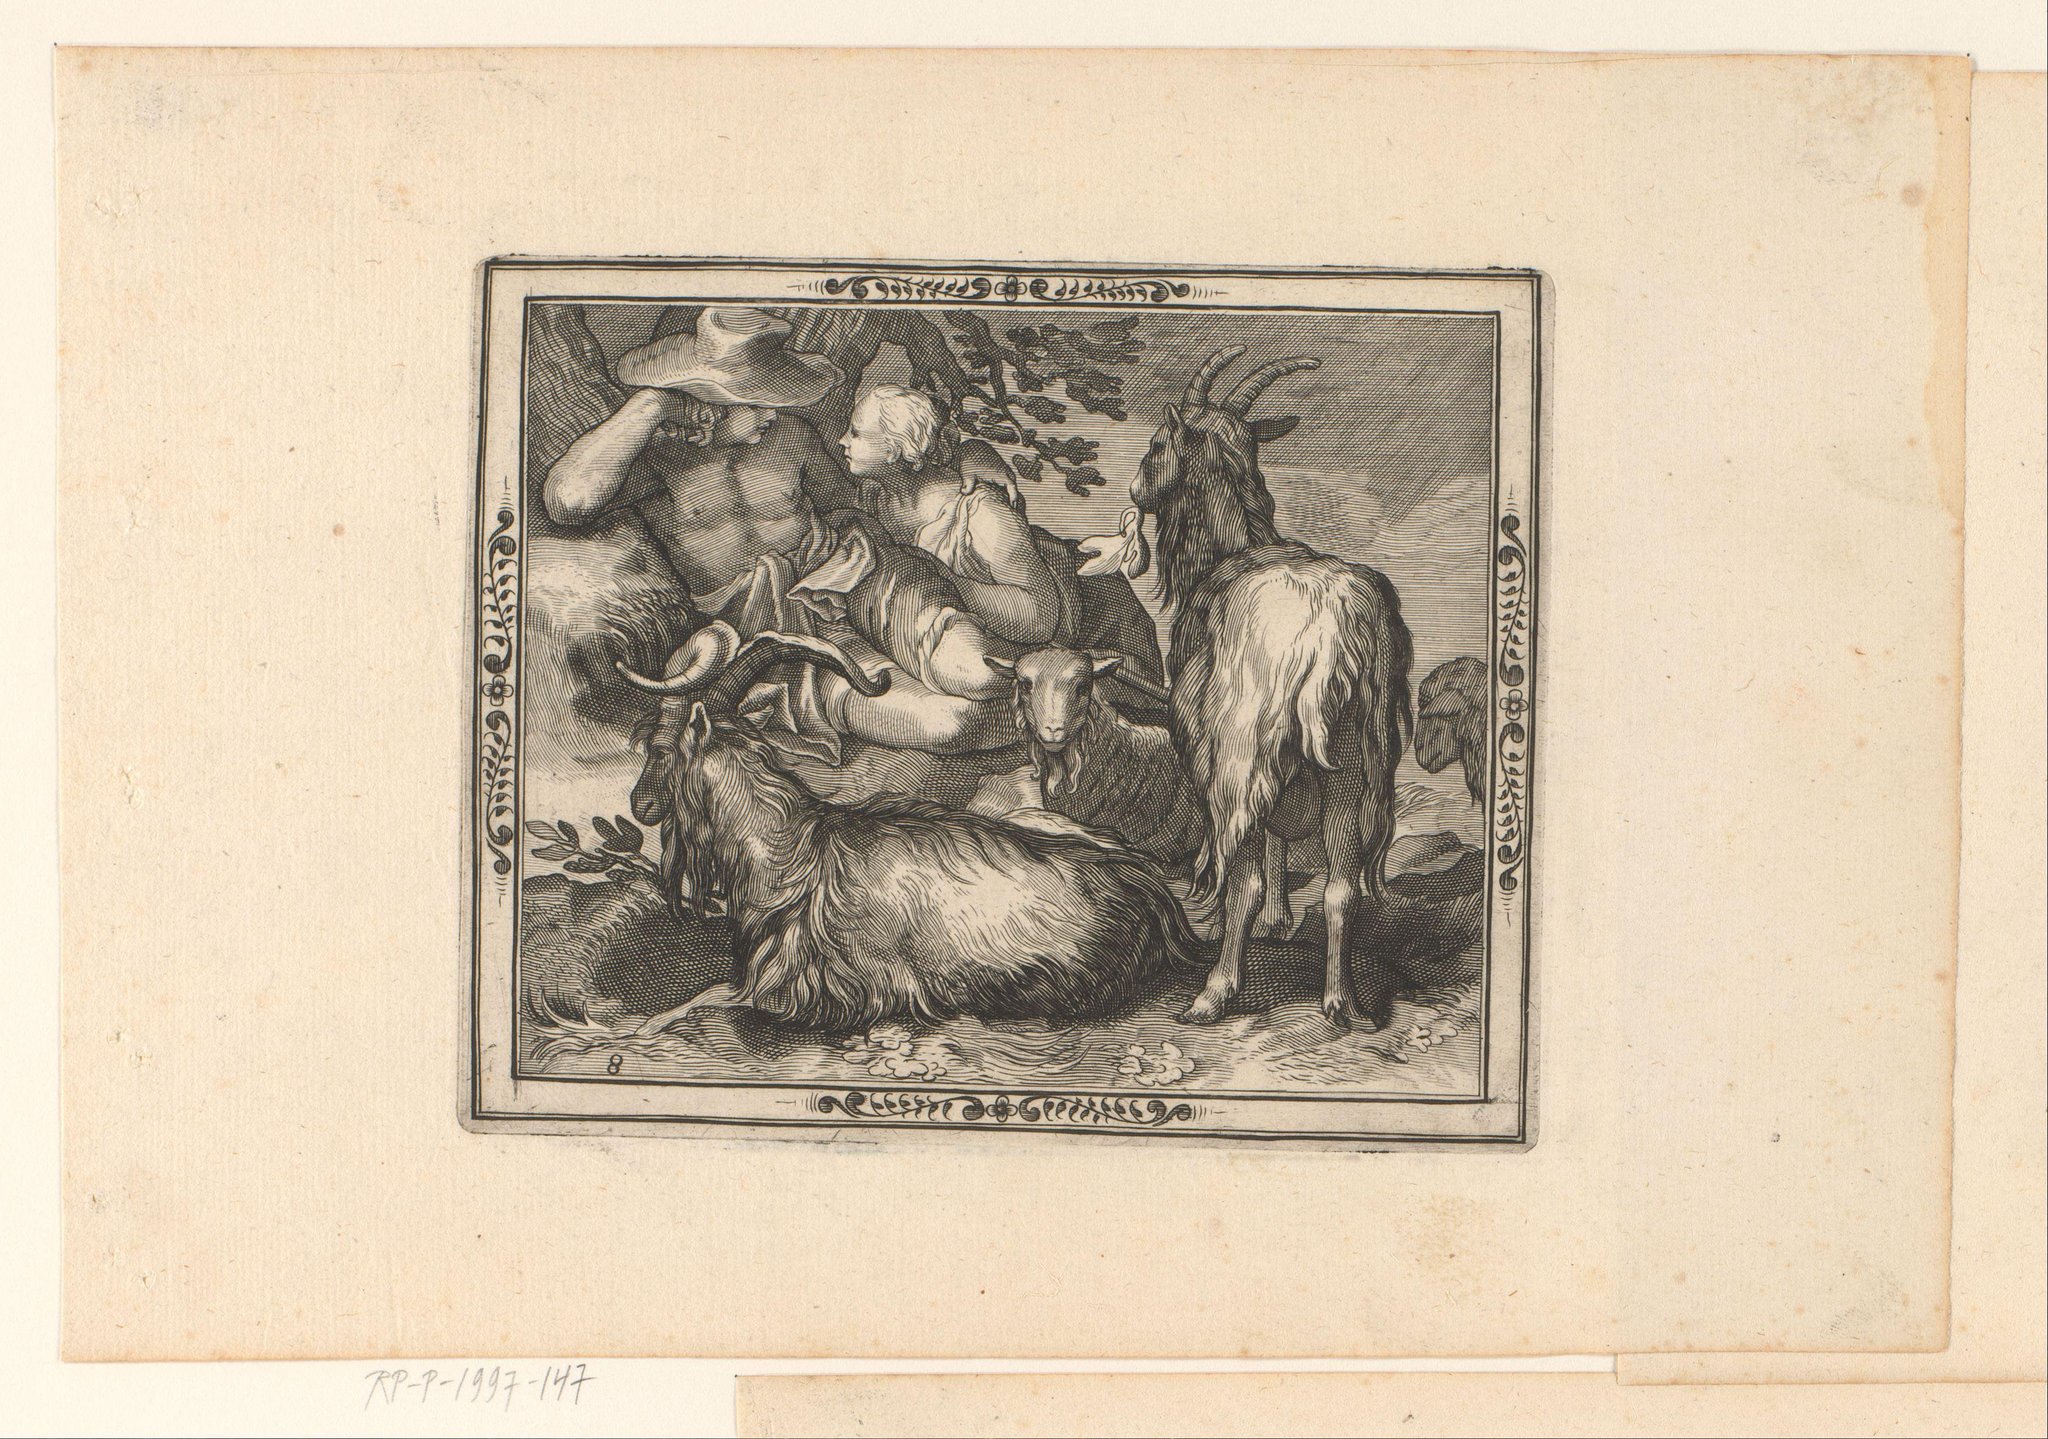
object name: print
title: Geiten met minnend paar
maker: jean leclerc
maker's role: print maker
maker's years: 1587-1633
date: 1597-1633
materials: paper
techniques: engraving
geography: france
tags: goat, couple of lovers